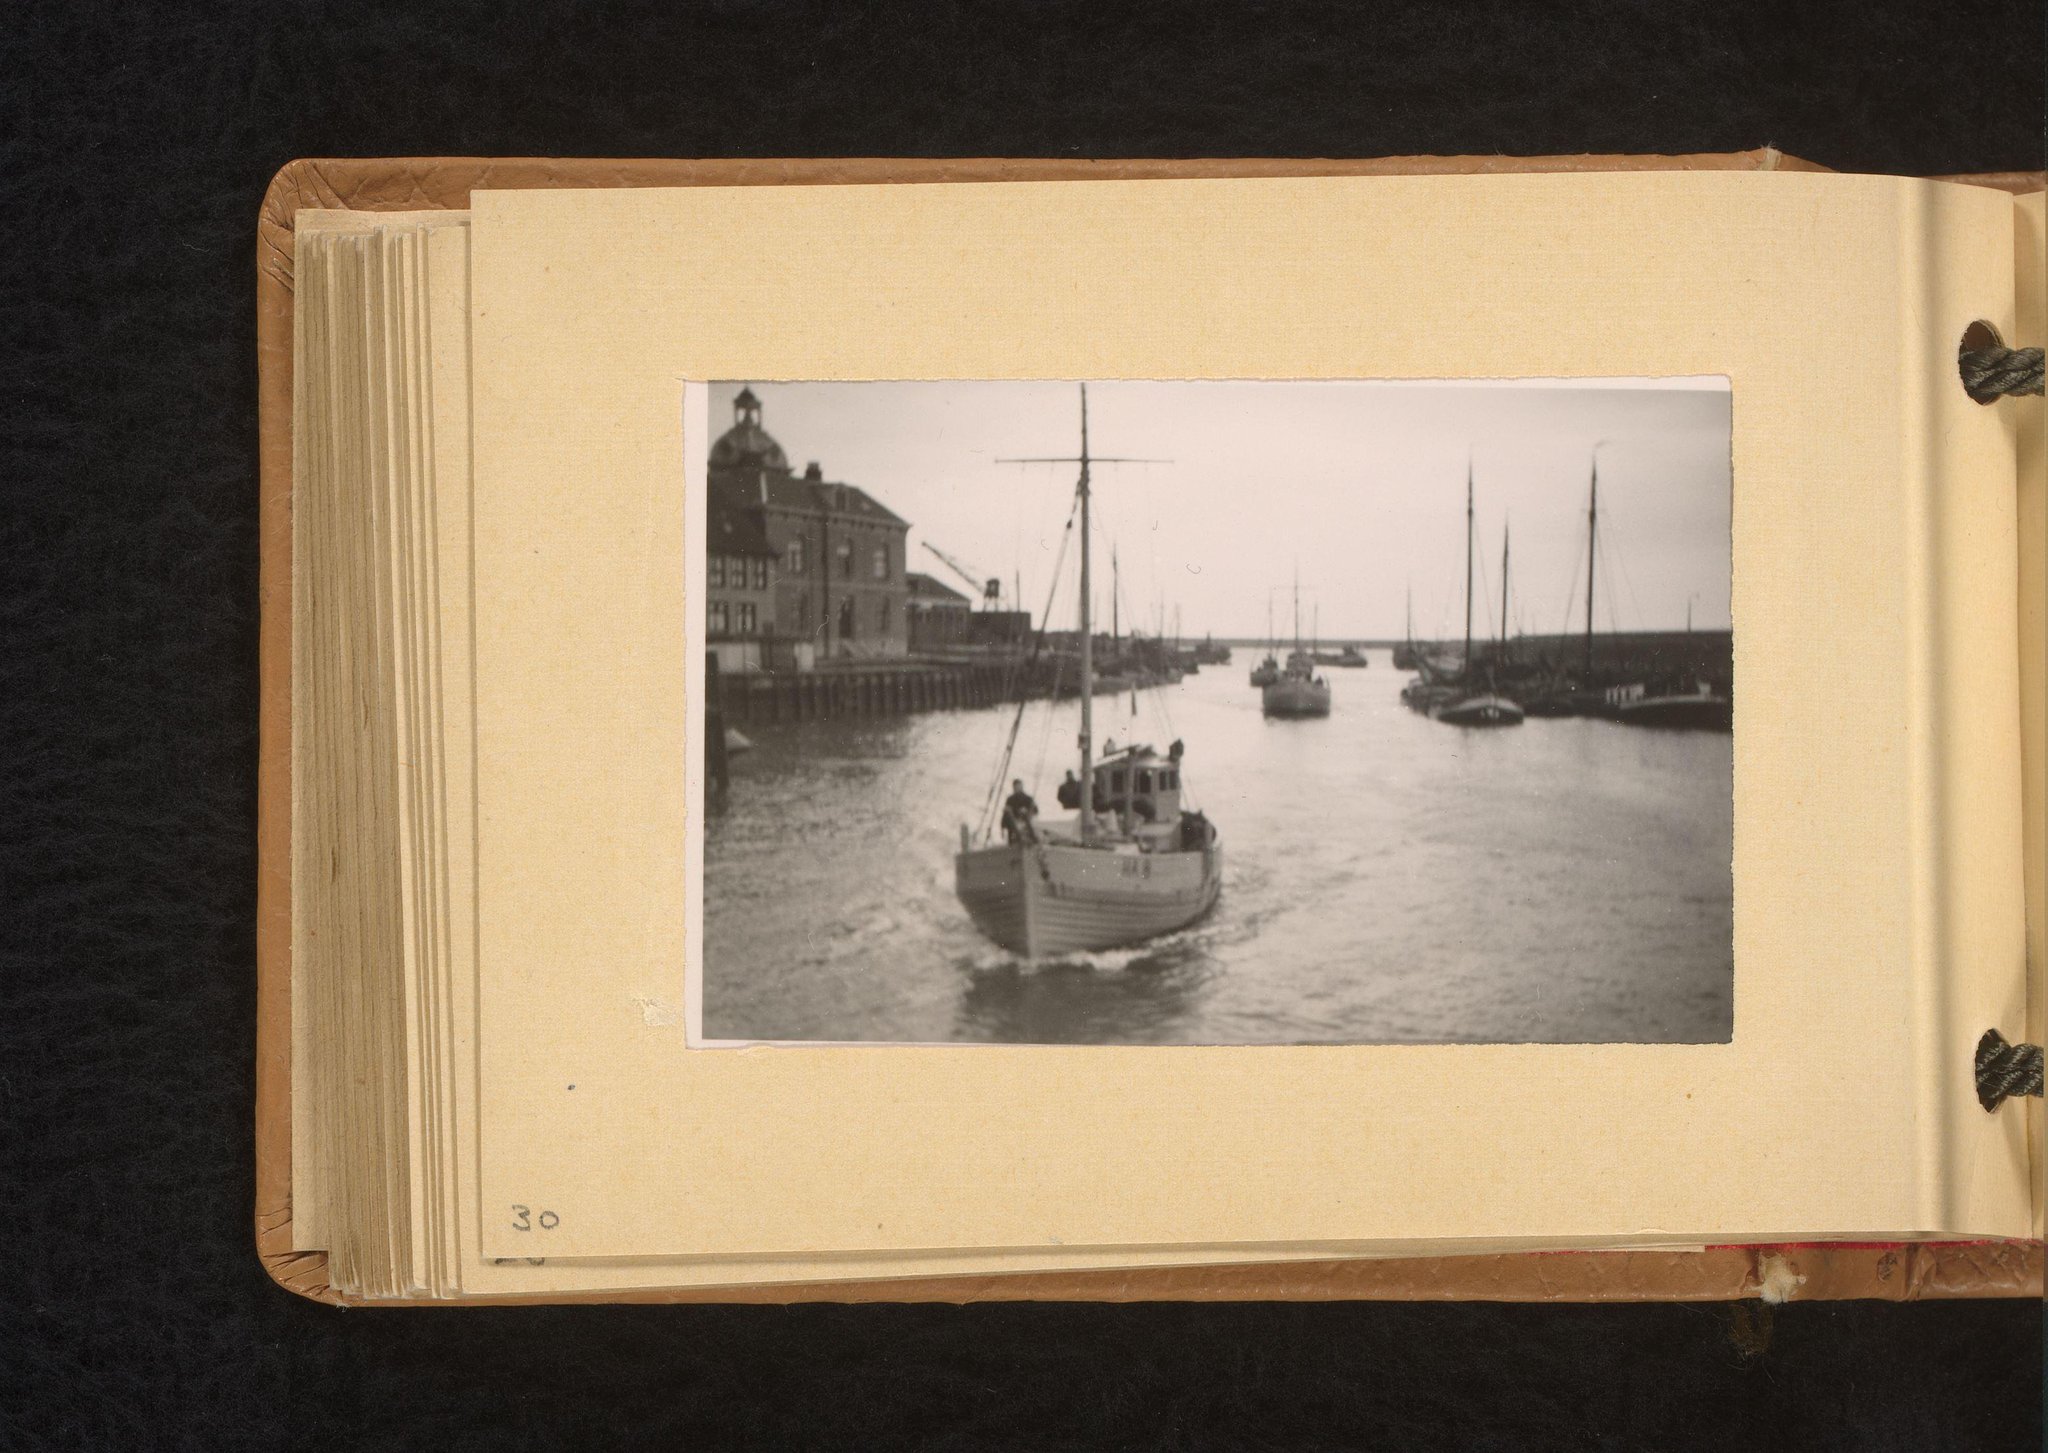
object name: album leaf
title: Schepen van de Kriegsmarine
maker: Anonymous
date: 1940-1943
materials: paper, photographic support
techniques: gelatin silver print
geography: netherlands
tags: harbour, navy (+ motor ships), occupation ~ war, netherlands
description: Albumblad met een foto van een aantal kleine schepen van de Kriegsmarine die een haven uitvaren. Onderdeel van een klein album van de Kriegsmarine in Nederland.